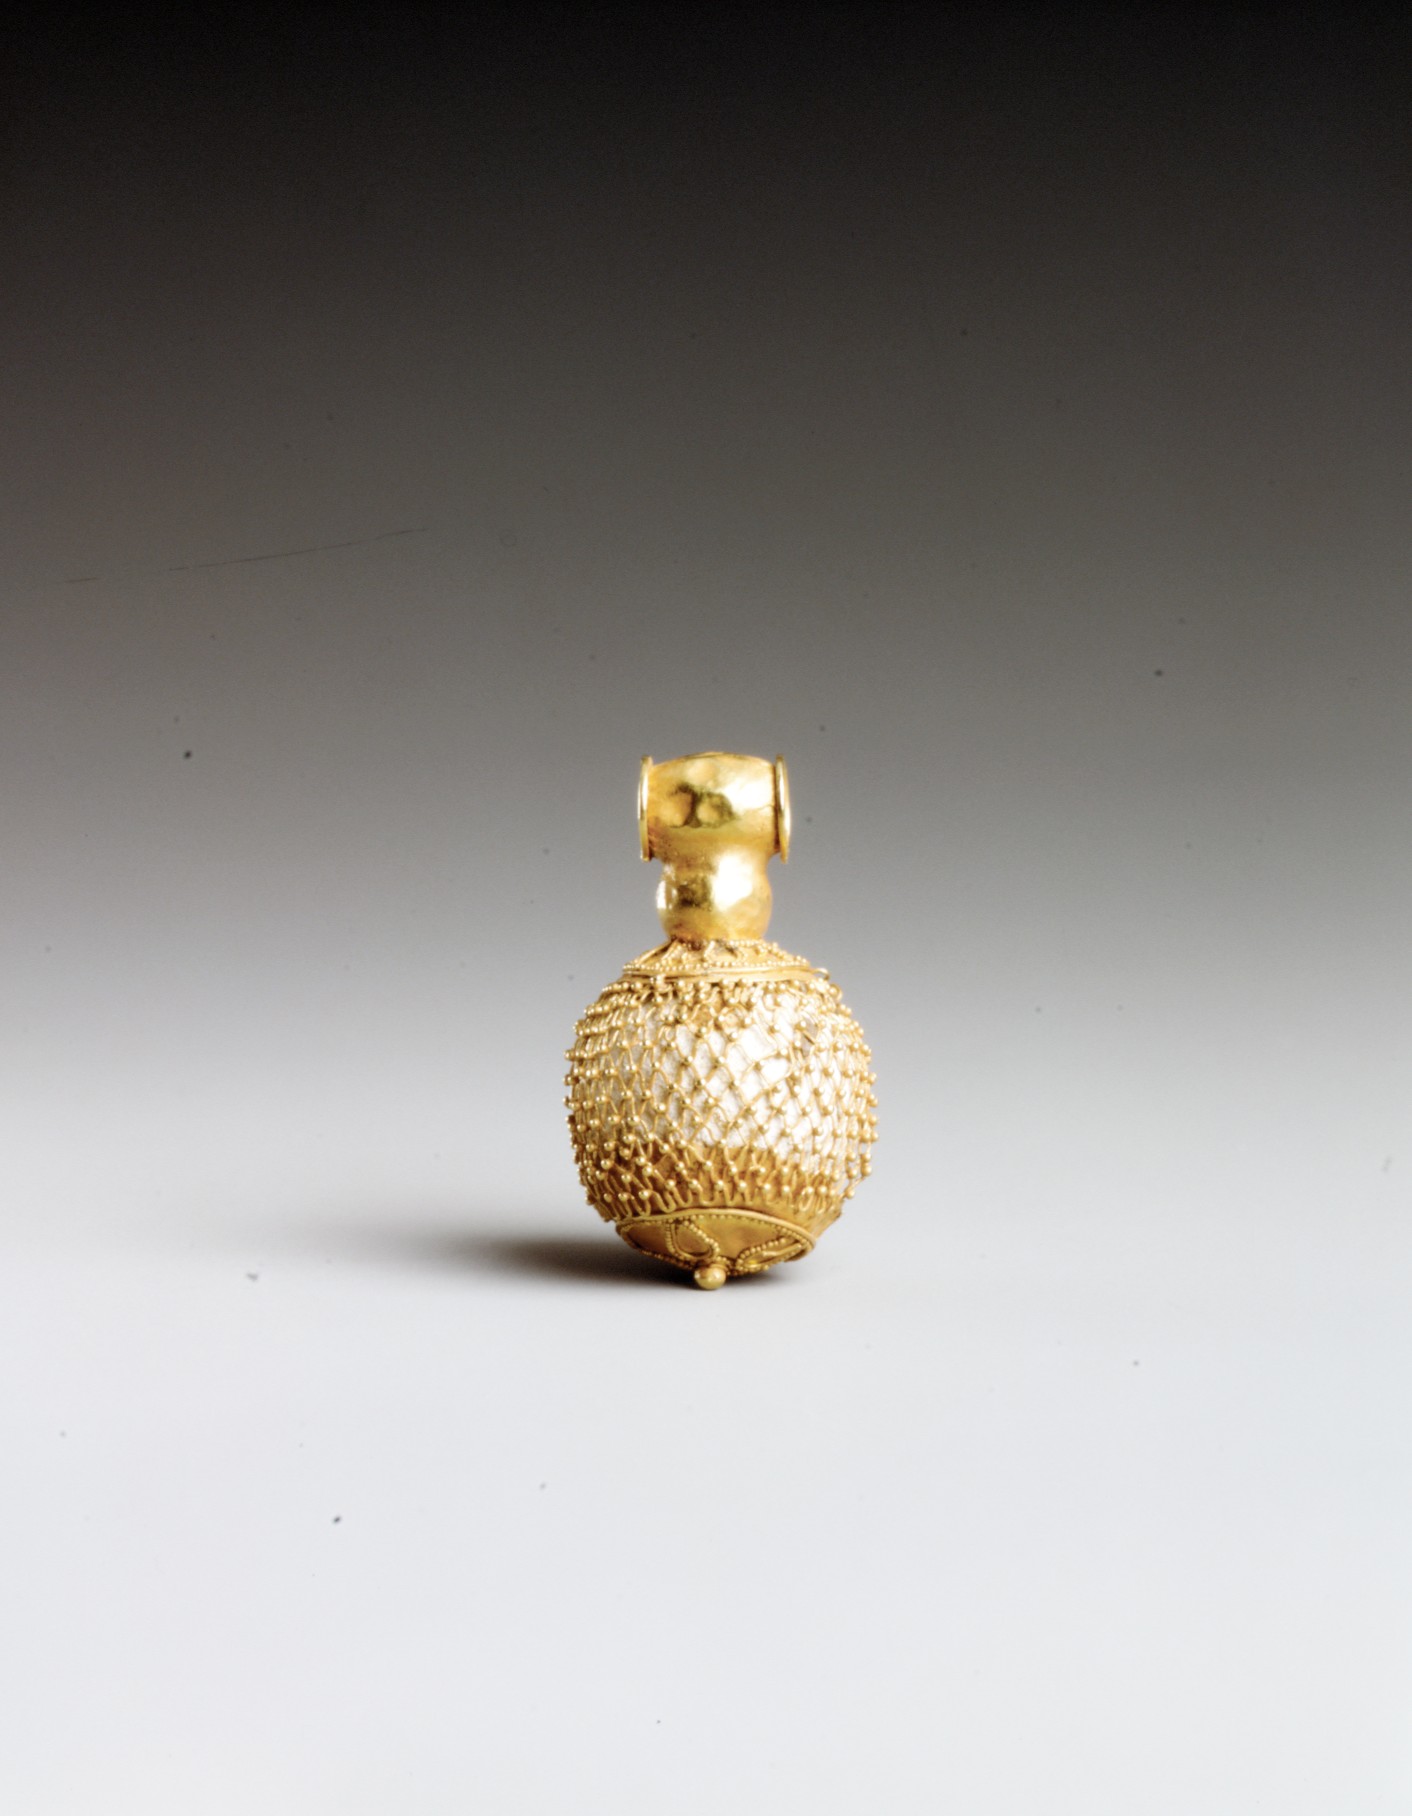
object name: pendant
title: Gold pendant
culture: greek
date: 400-301 BCE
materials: gold